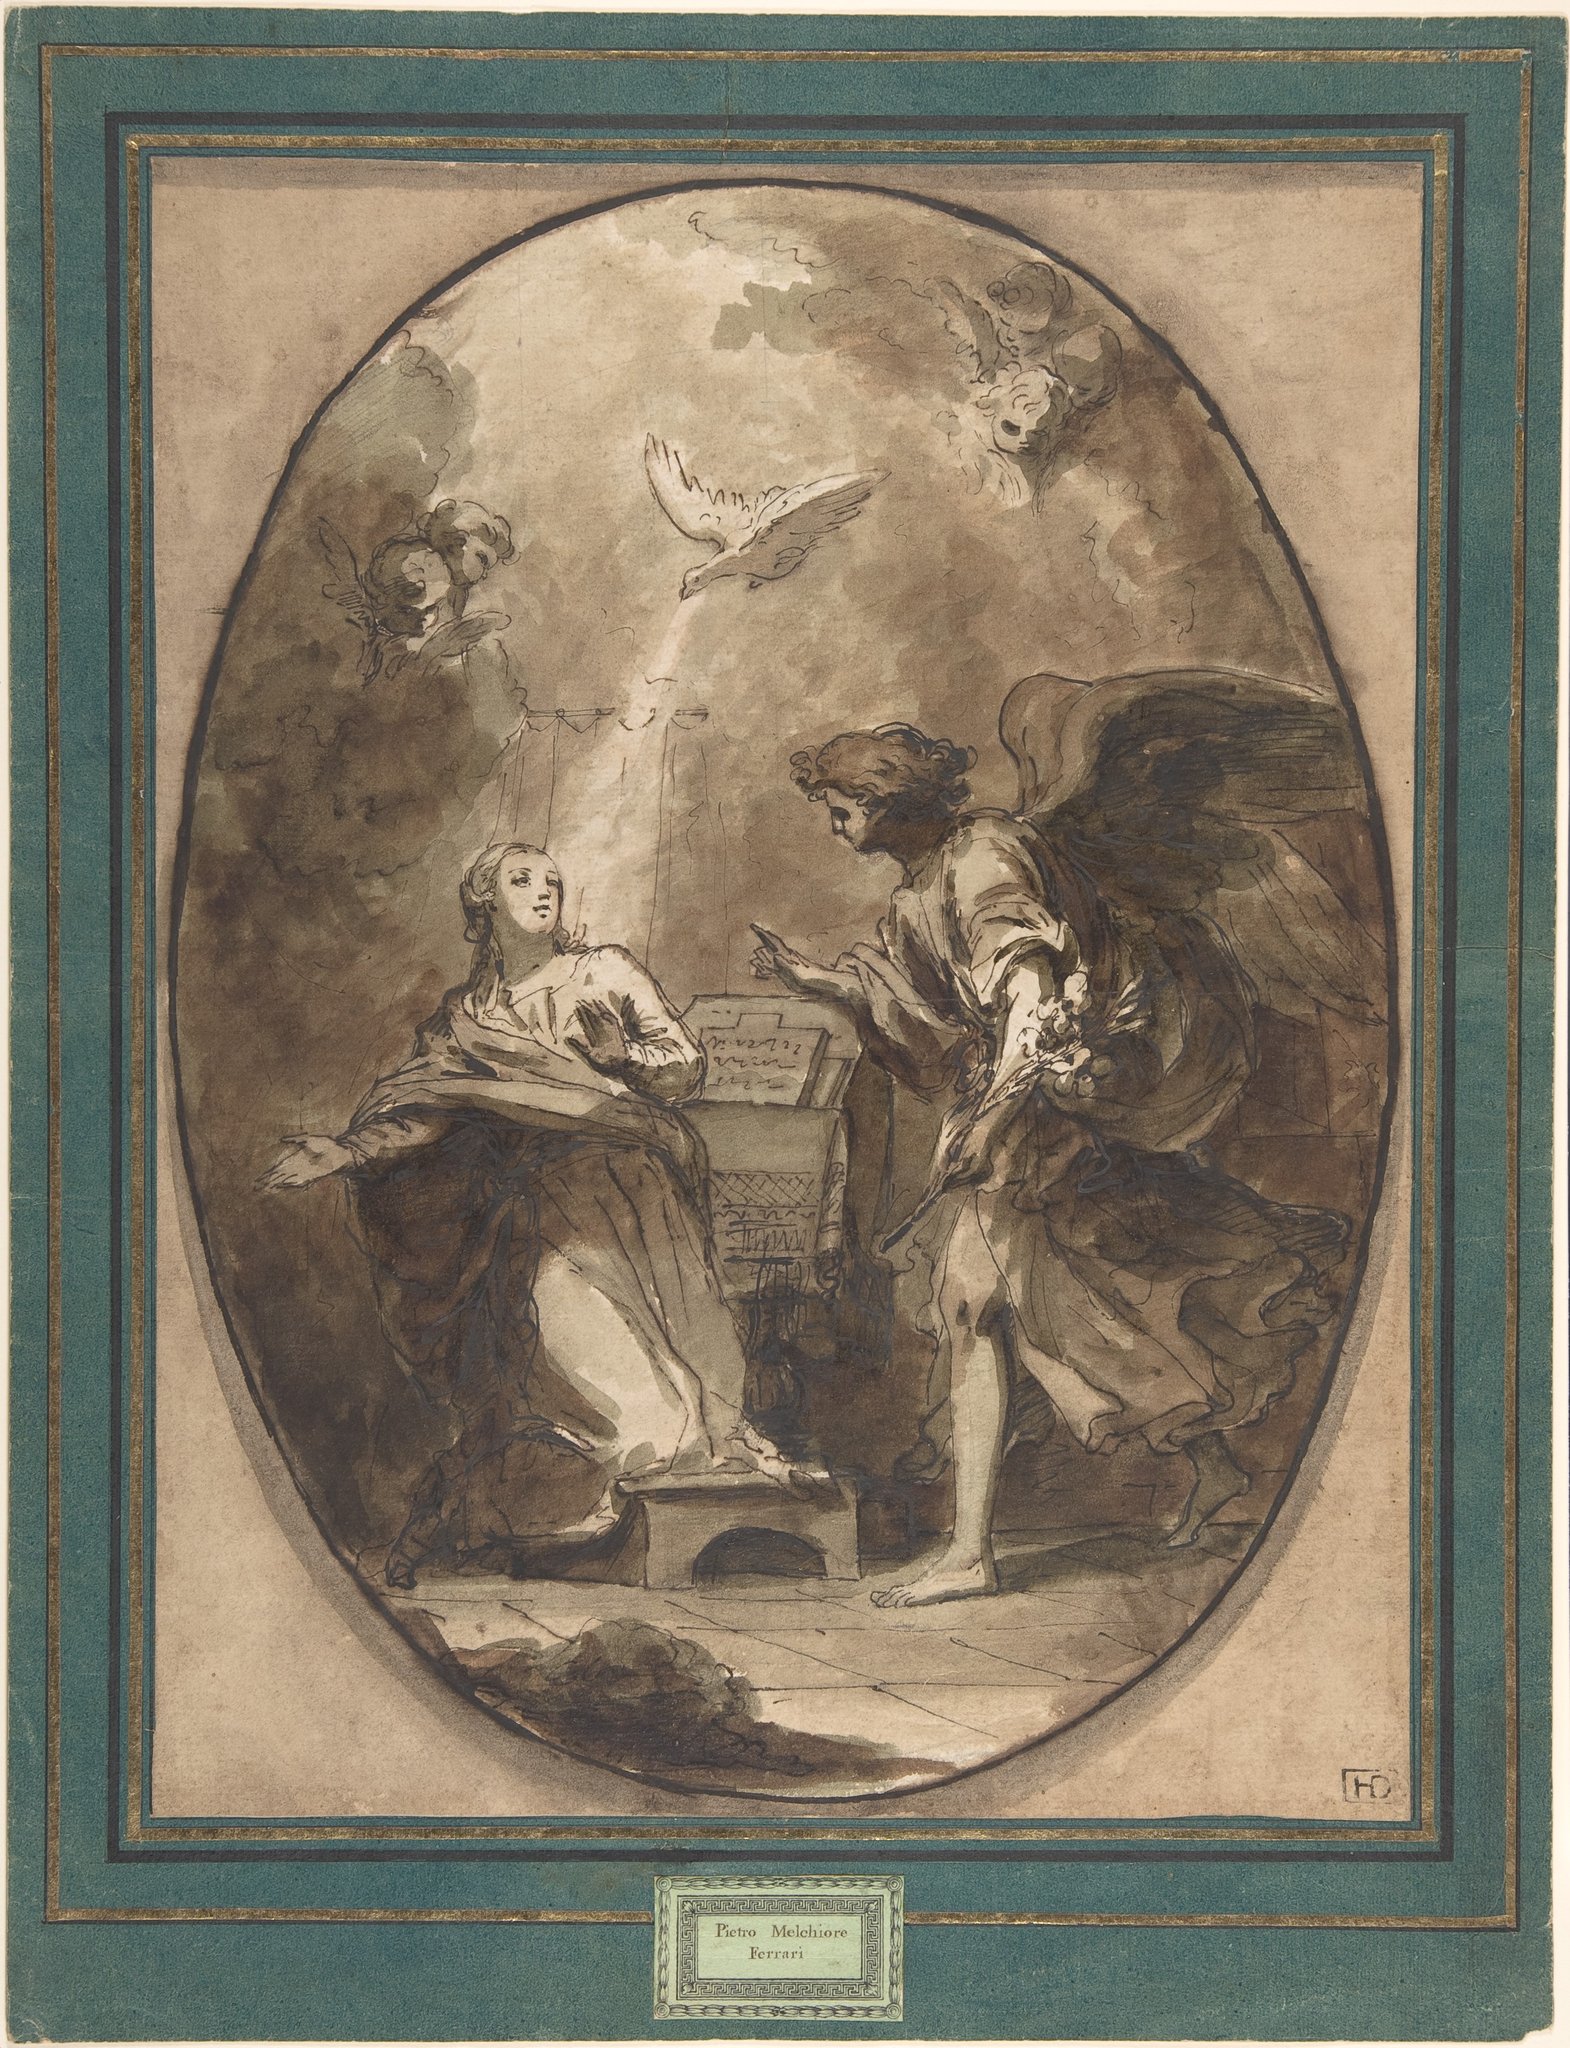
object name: drawing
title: The Annunciation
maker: pietro melchiorre ferrari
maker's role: artist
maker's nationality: italian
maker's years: 1735-1787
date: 1735-1787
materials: chalk, ink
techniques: brush, pen, drawing, wash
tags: annunciation